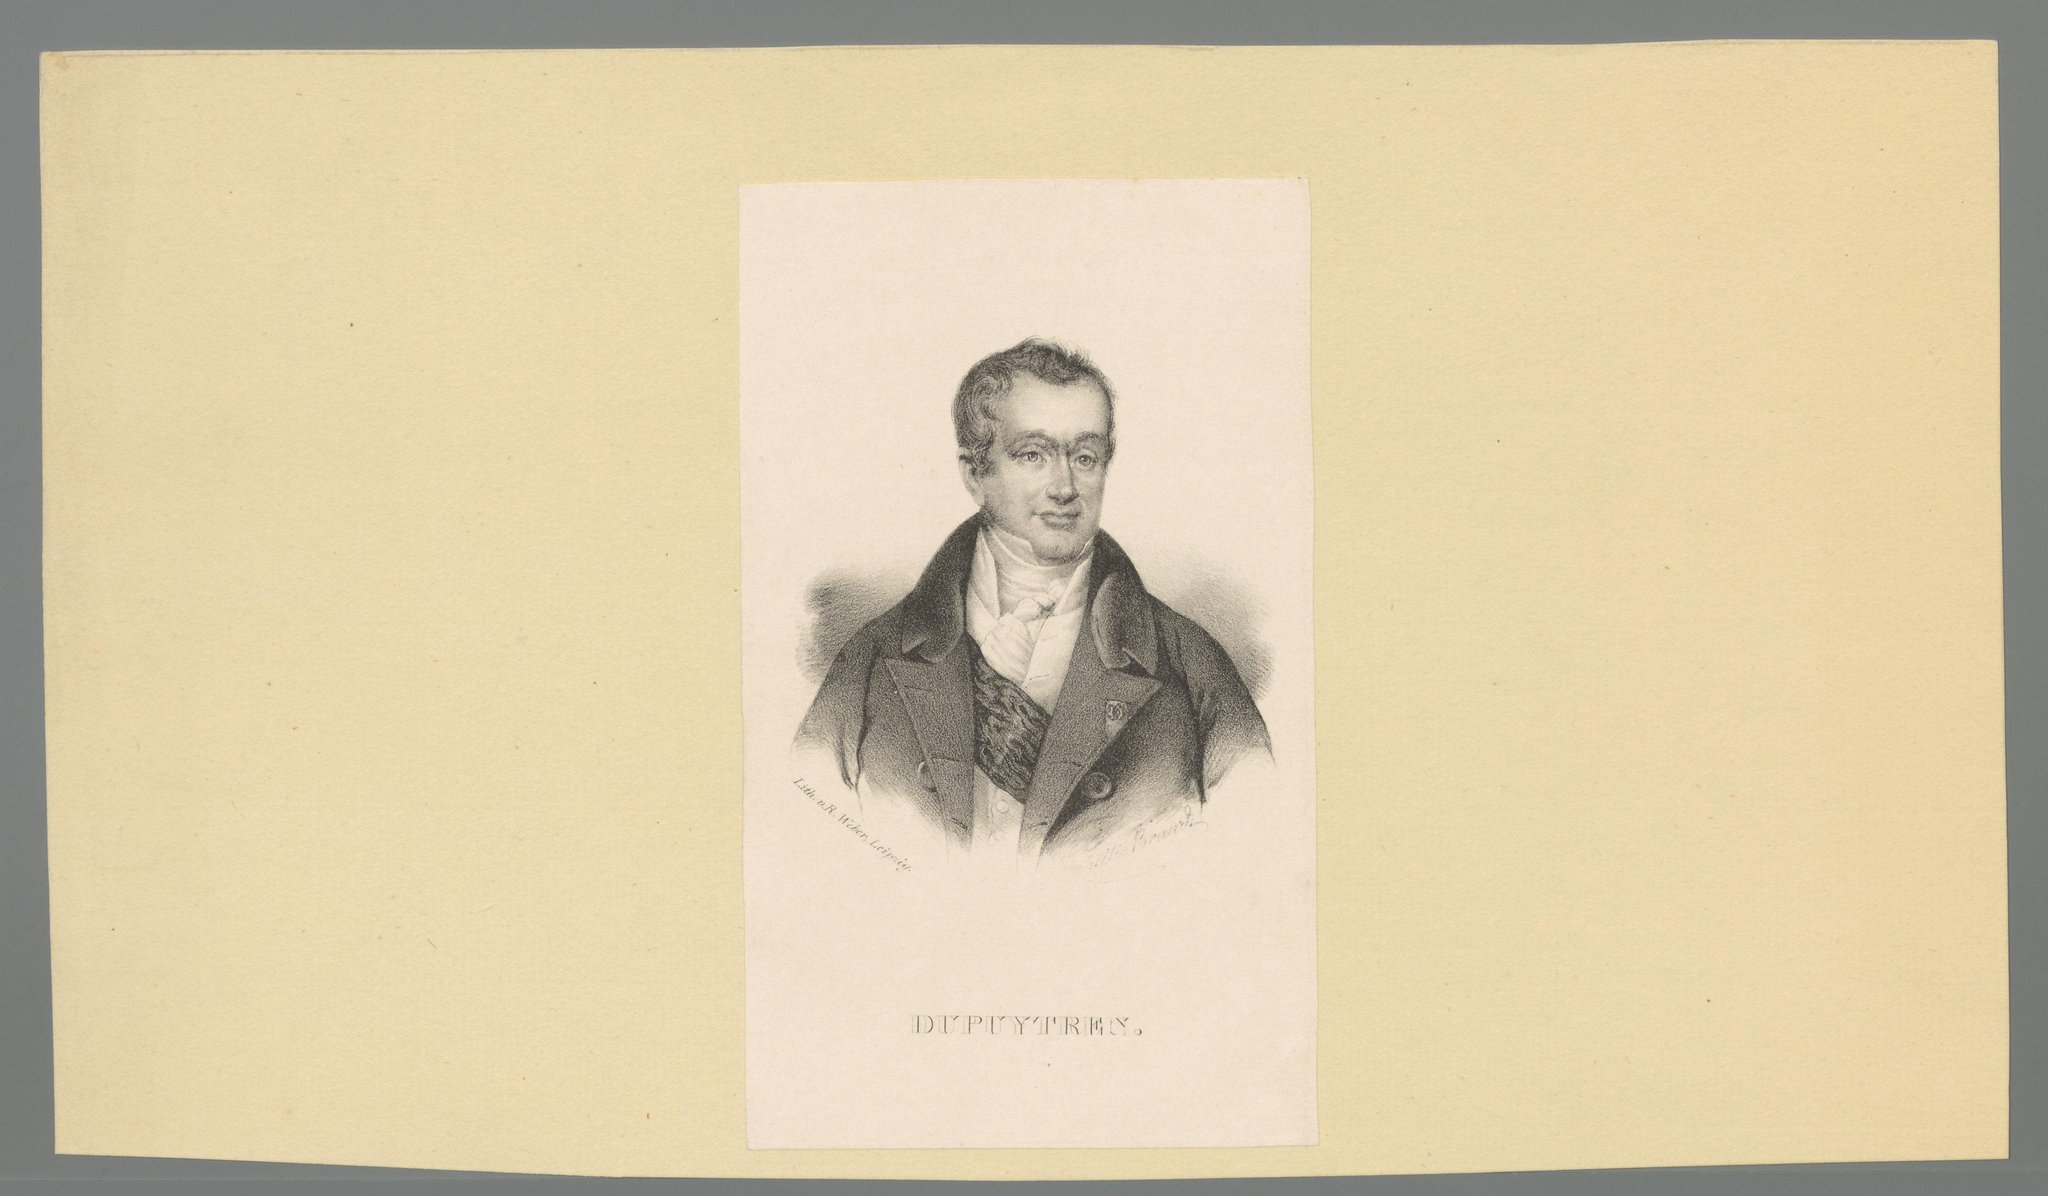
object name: print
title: Dupuytren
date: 1825-1850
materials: paper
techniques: lithograph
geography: leipzig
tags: adult man, historical persons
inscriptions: collector's mark: Lugt 2228